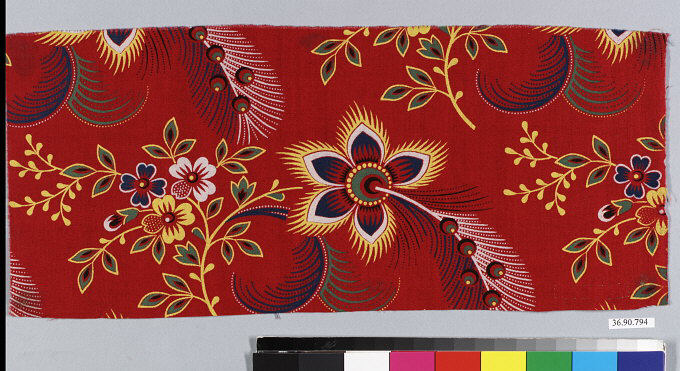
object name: piece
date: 1867-1900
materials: cotton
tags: flowers,leaves